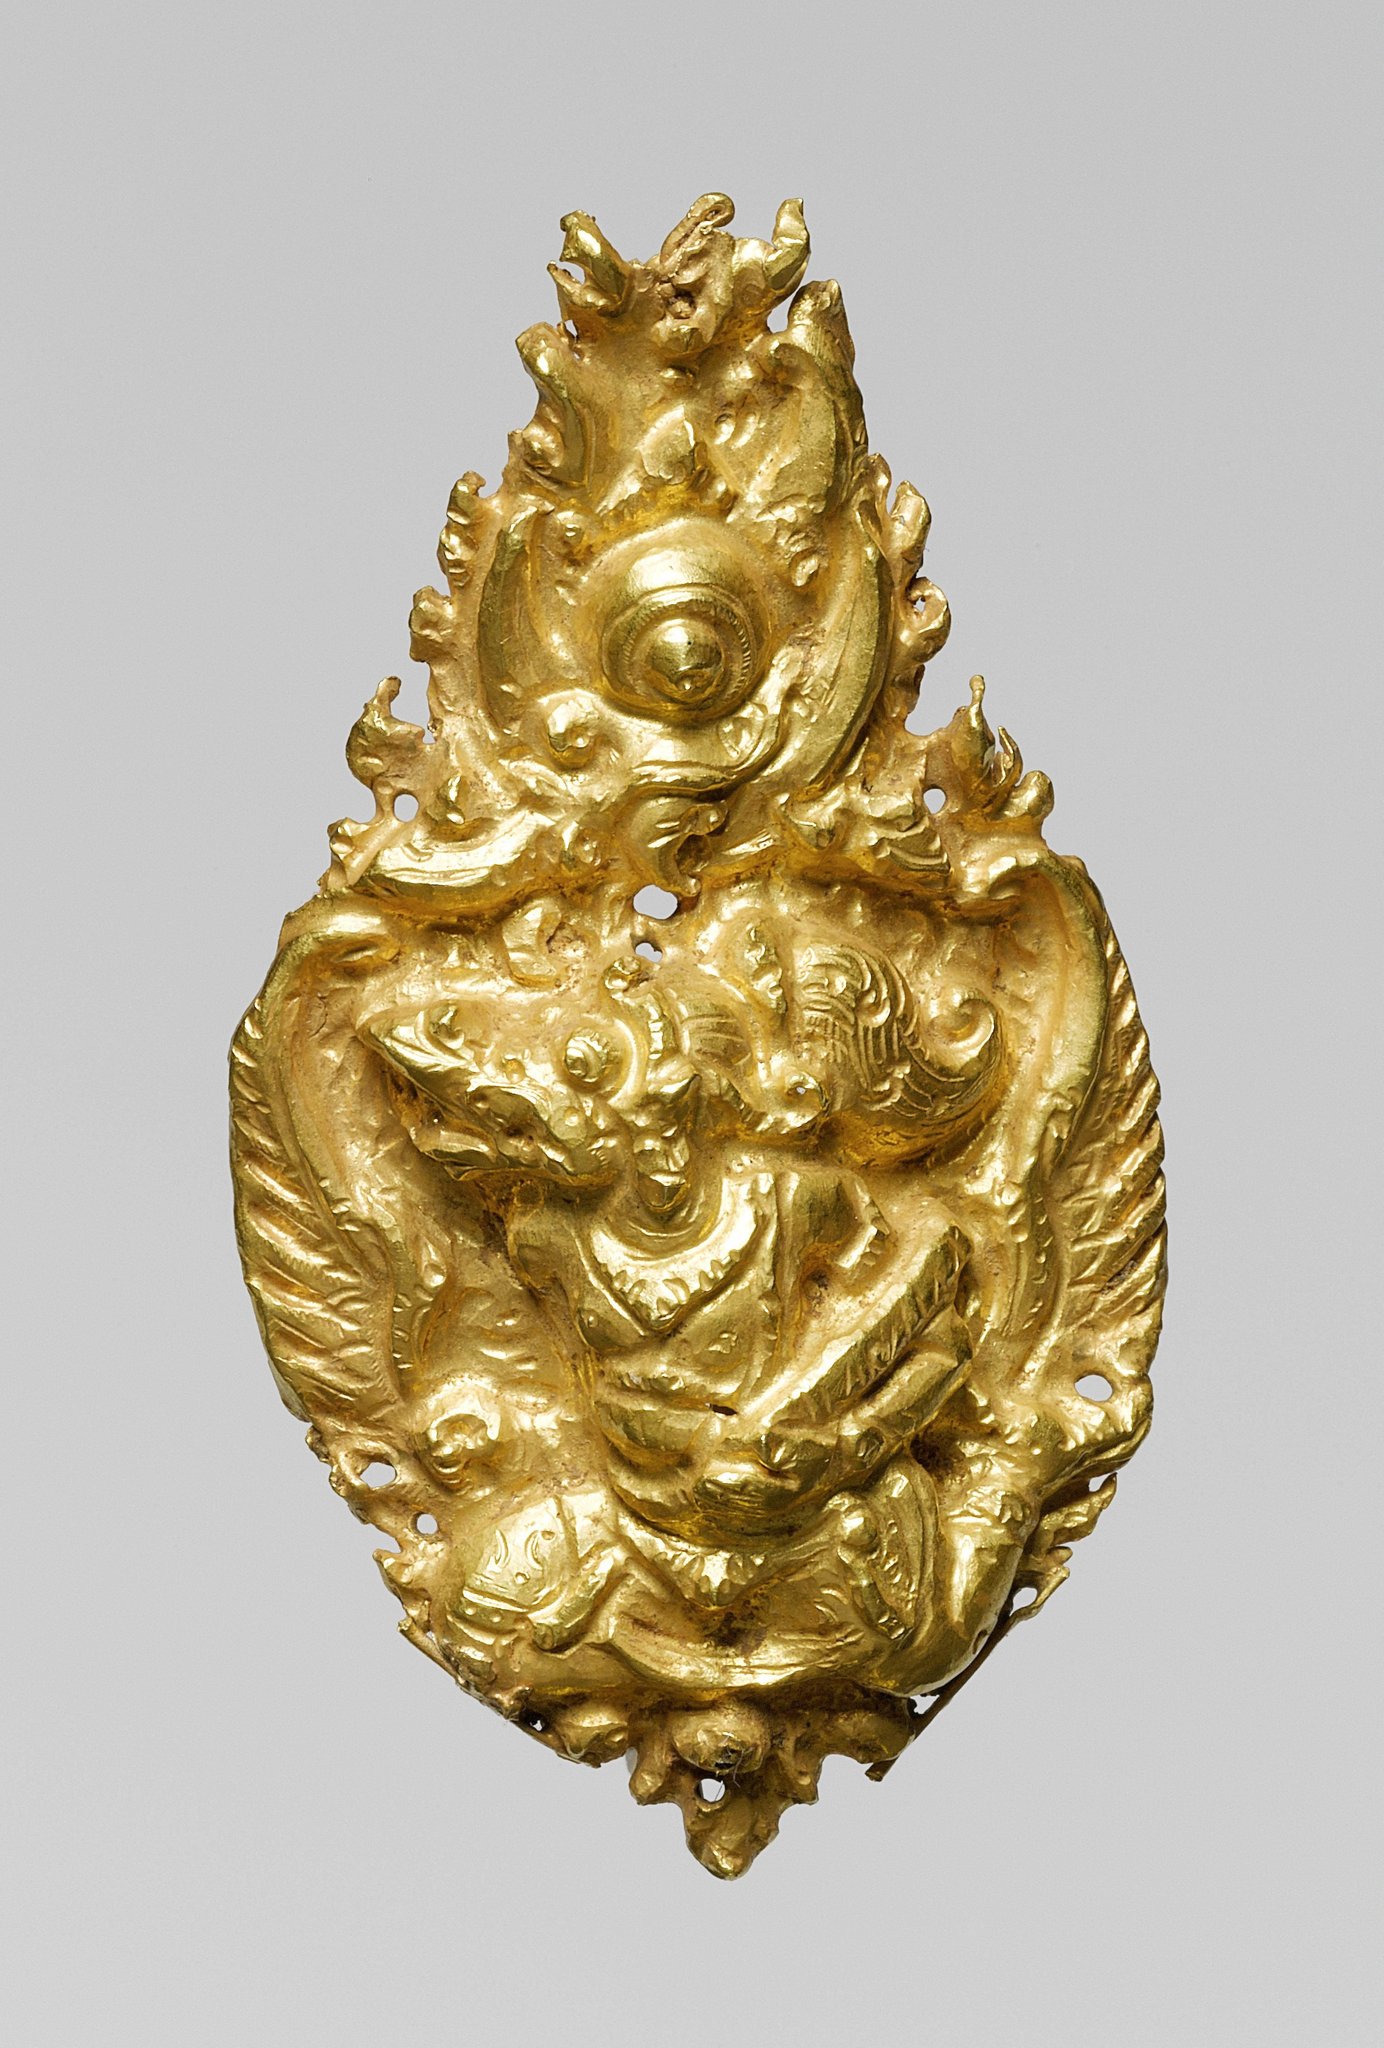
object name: decoratief object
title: Gold plaque with Garuda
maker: Anonymous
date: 1300-1400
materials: gold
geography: indonesia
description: Bladvormig ornament met een voorstelling van een vliegende vogel (Garuda), boven diens hoofd een éénogige kala. Een haakje aan de achterkant.